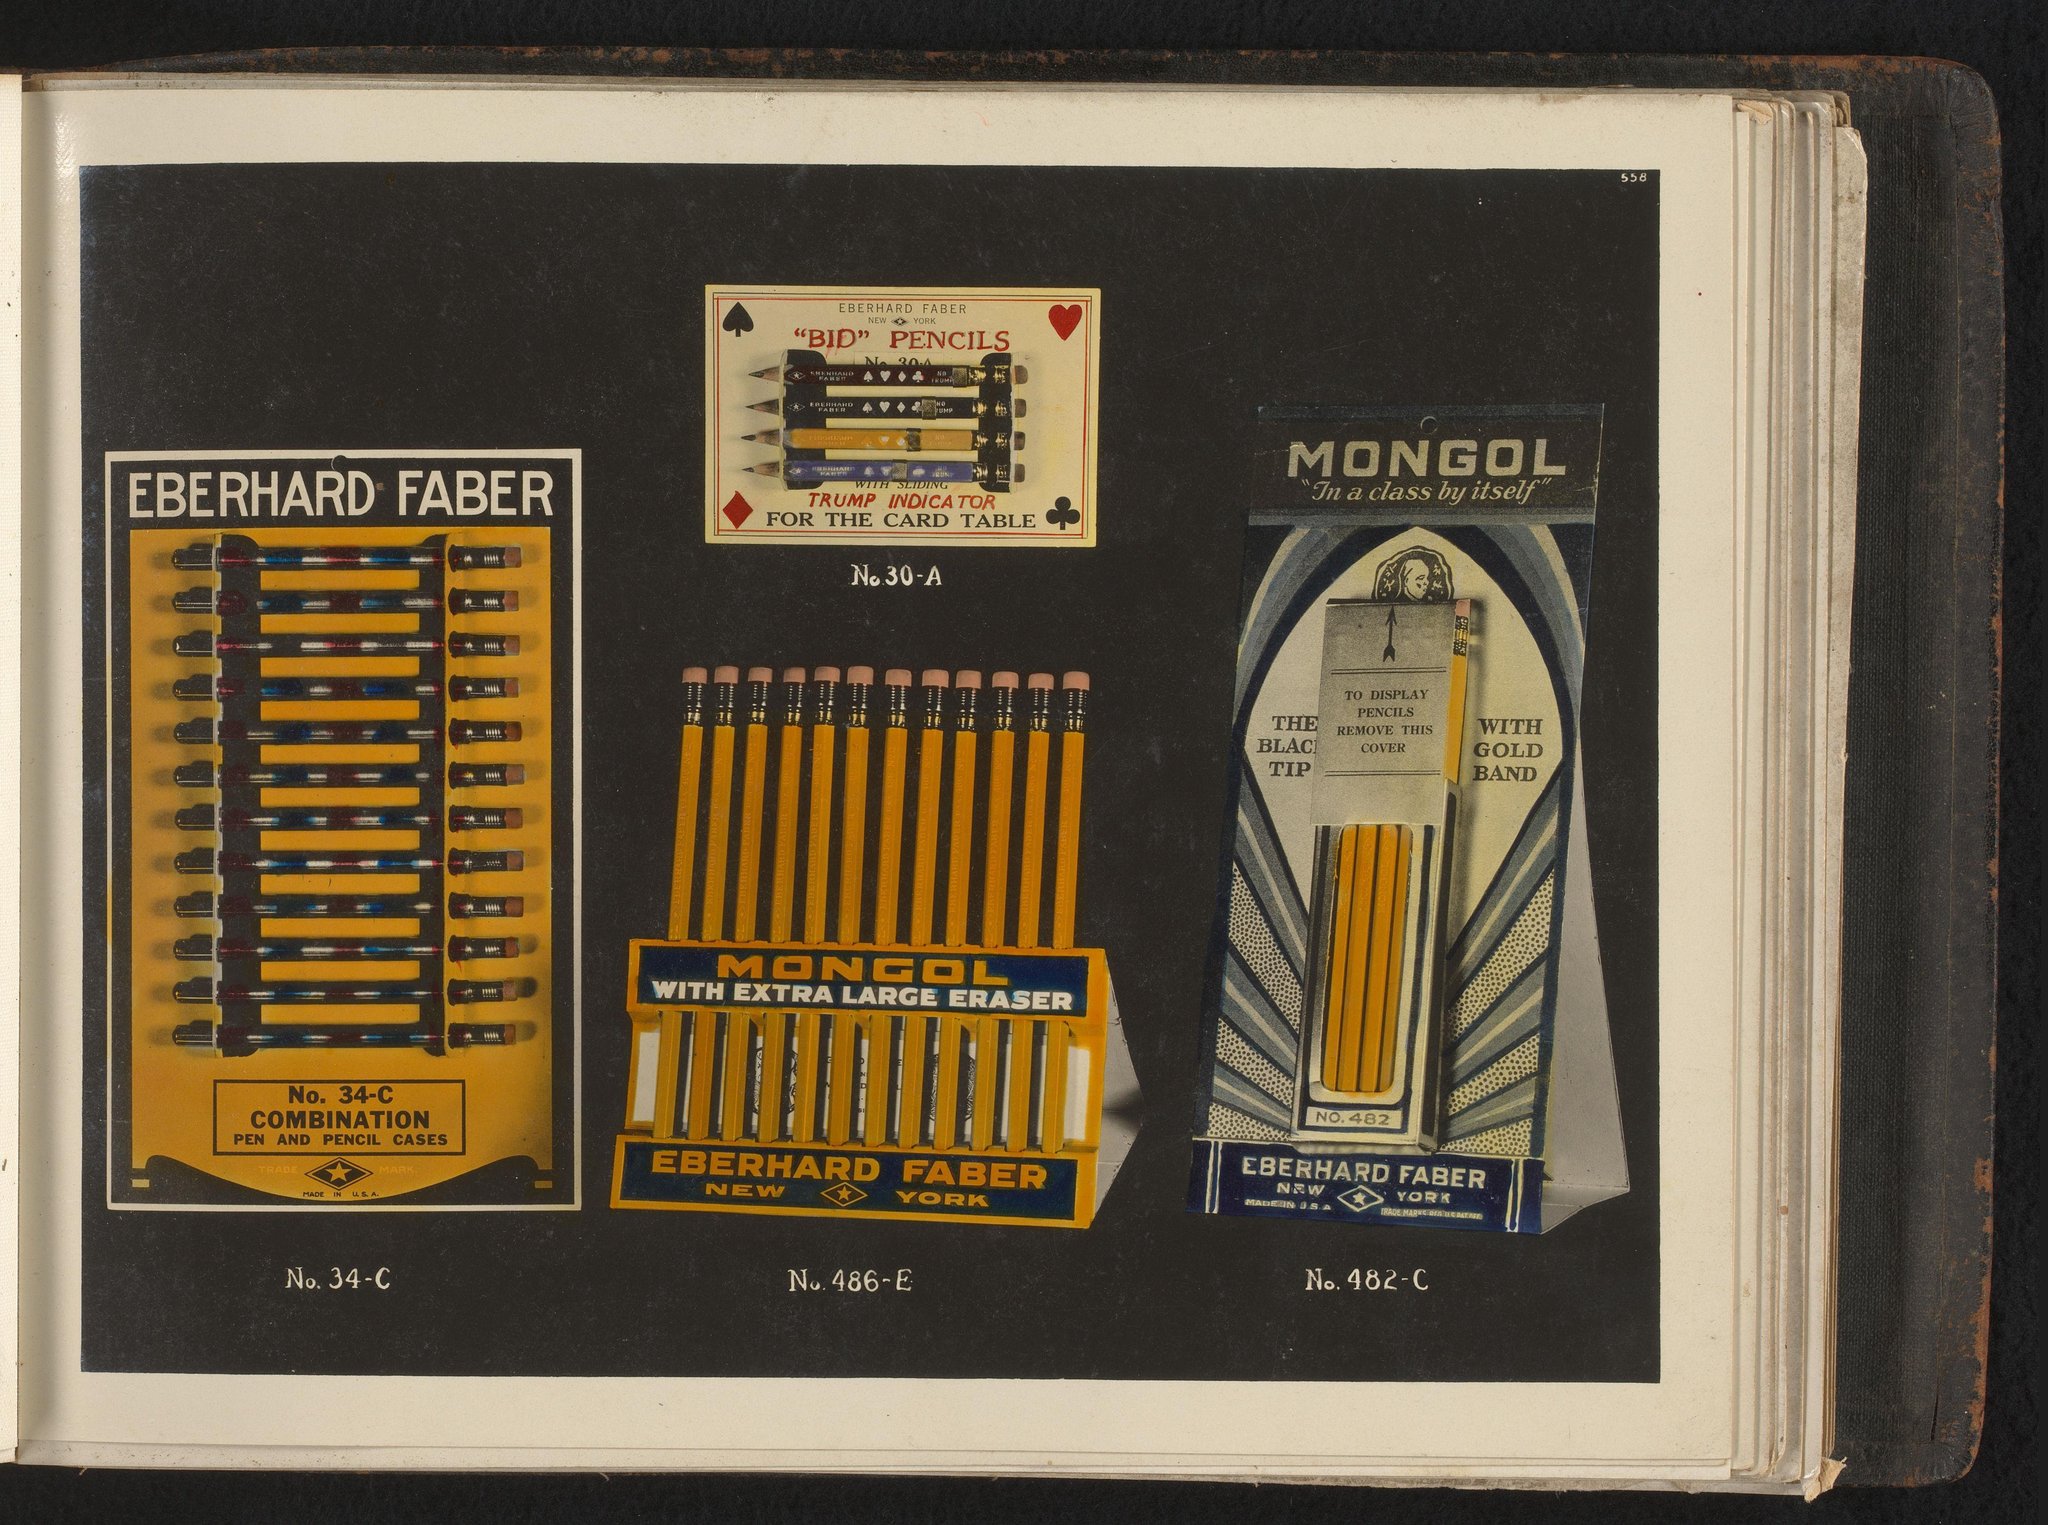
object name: album leaf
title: Standaarden met potloden van Eberhard Faber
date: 1915-1935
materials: paper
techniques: gelatin silver print, hand coloring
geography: springfield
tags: pencil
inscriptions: stamp: ‘Paramount/ Commercial Studios/ 145 Chestnut St./ Springfield - Mass.’, number: ‘558’